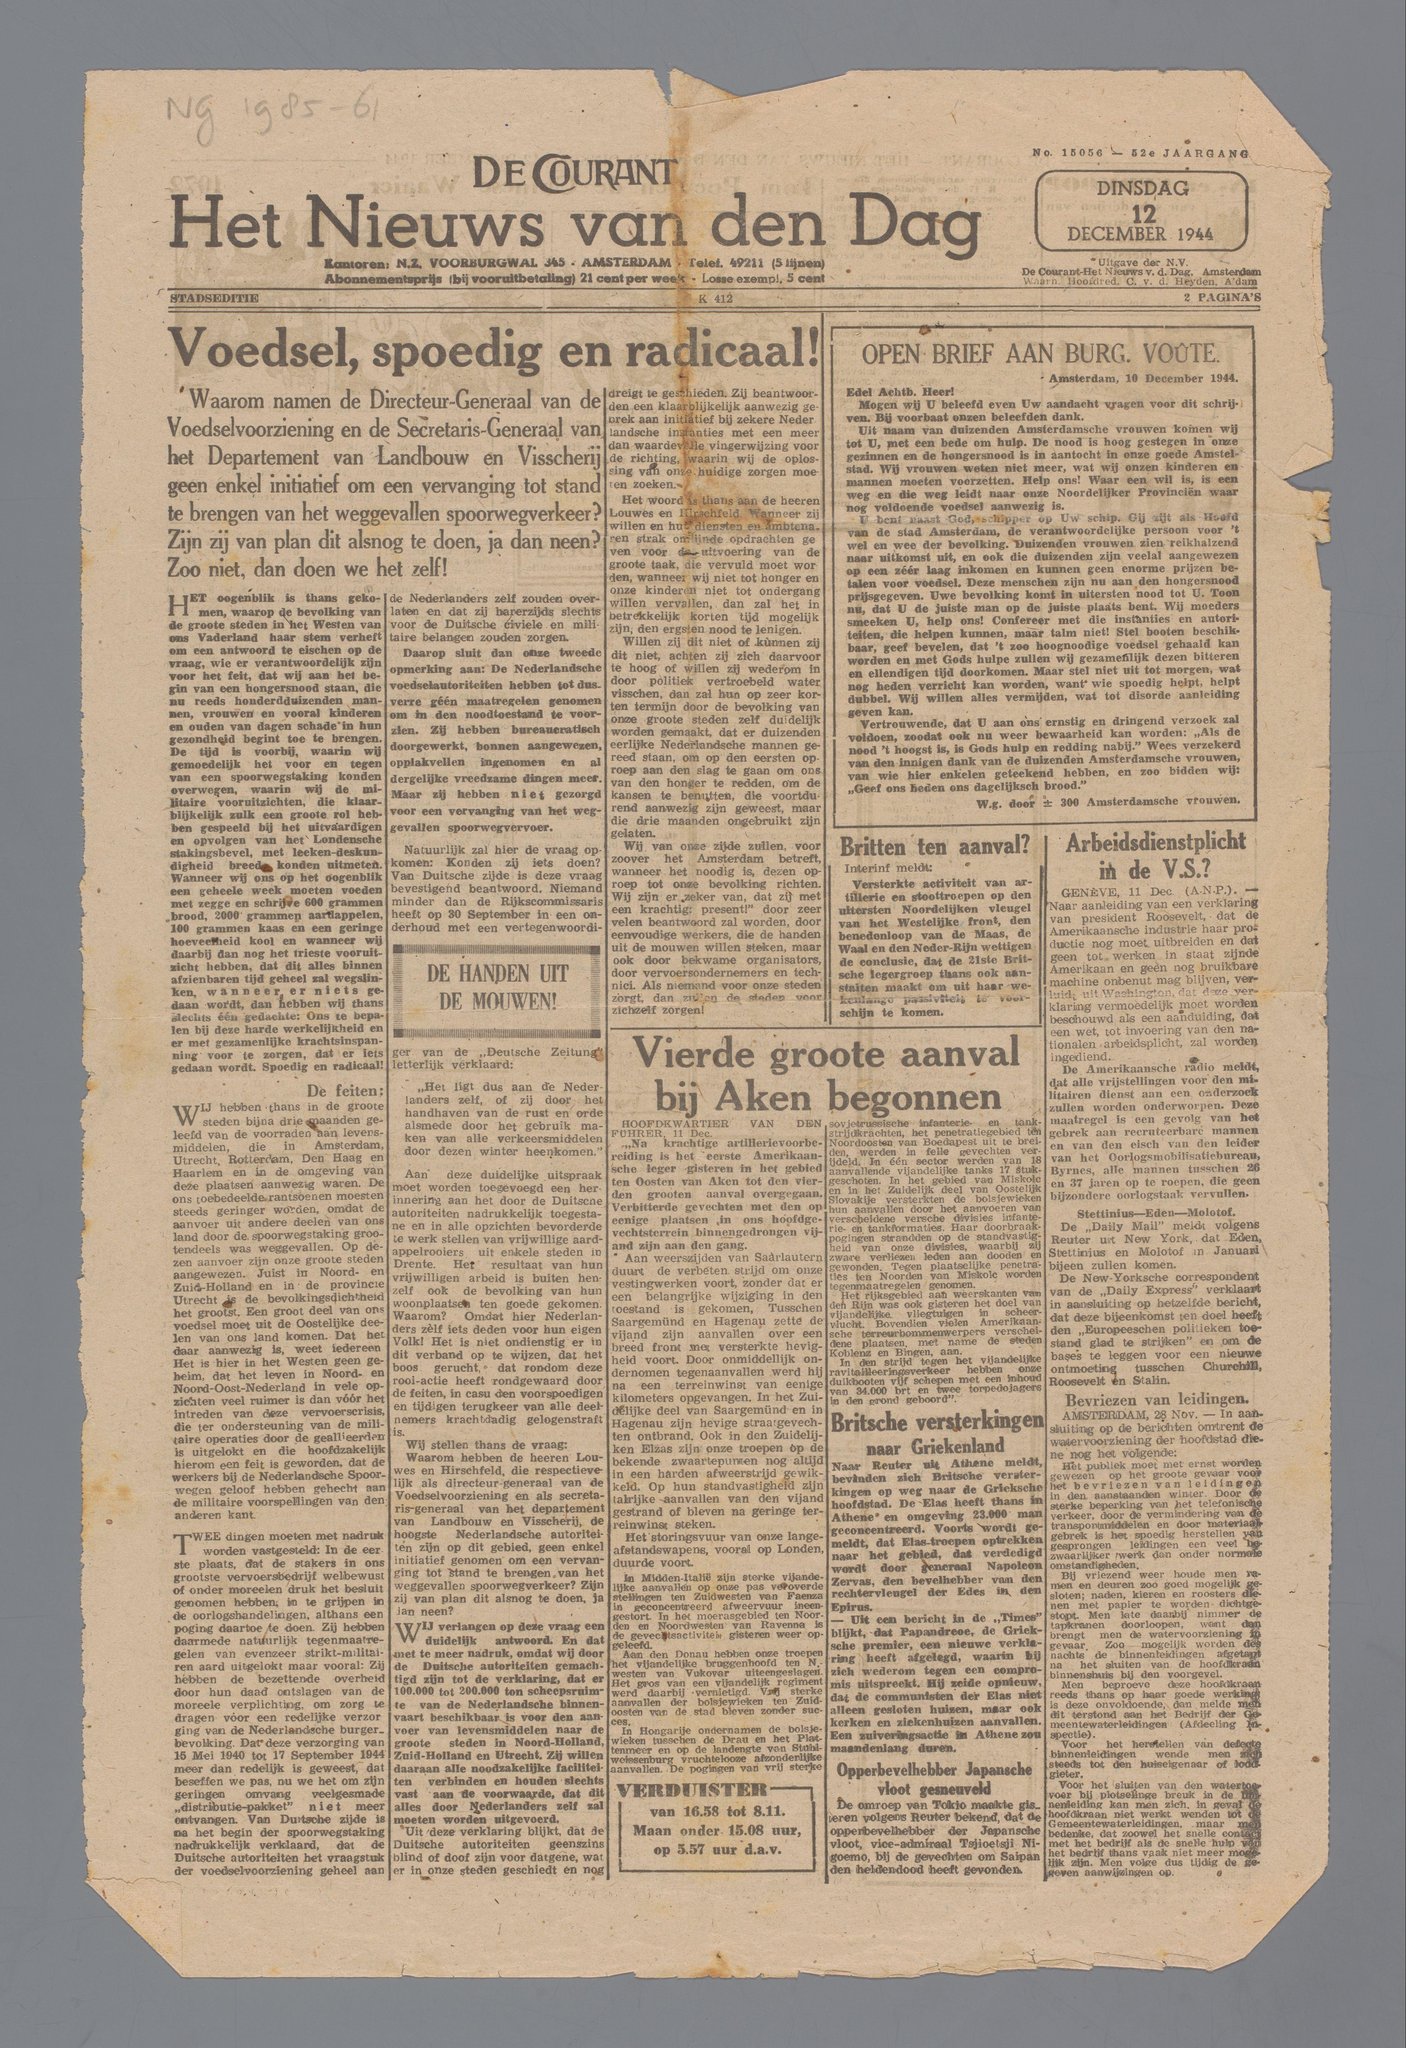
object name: newspaper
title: De Courant / Het Nieuws van den Dag, 1944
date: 1944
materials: ink, paper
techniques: printing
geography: amsterdam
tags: amsterdam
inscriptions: date: ‘12 december 1944’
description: Artikel over dreigend voedseltekort. Open brief van 300 vrouwen aan de Amsterdamse burgemeester Voûte.